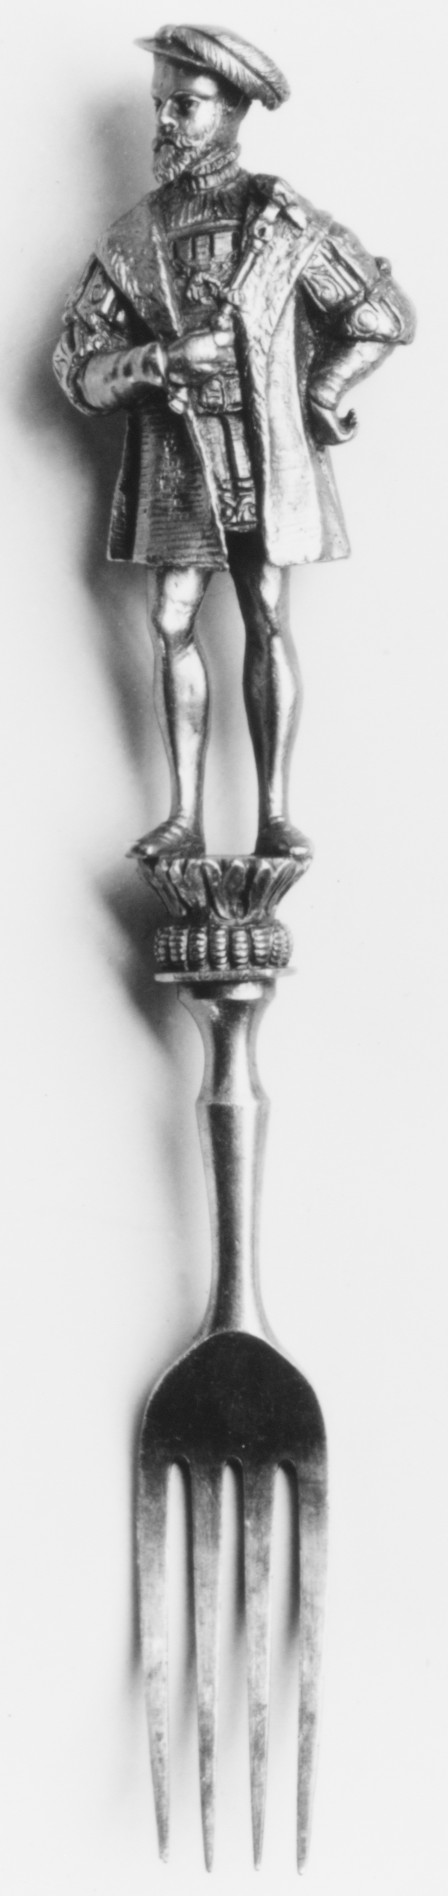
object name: fork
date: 1801-1900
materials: silver gilt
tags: men